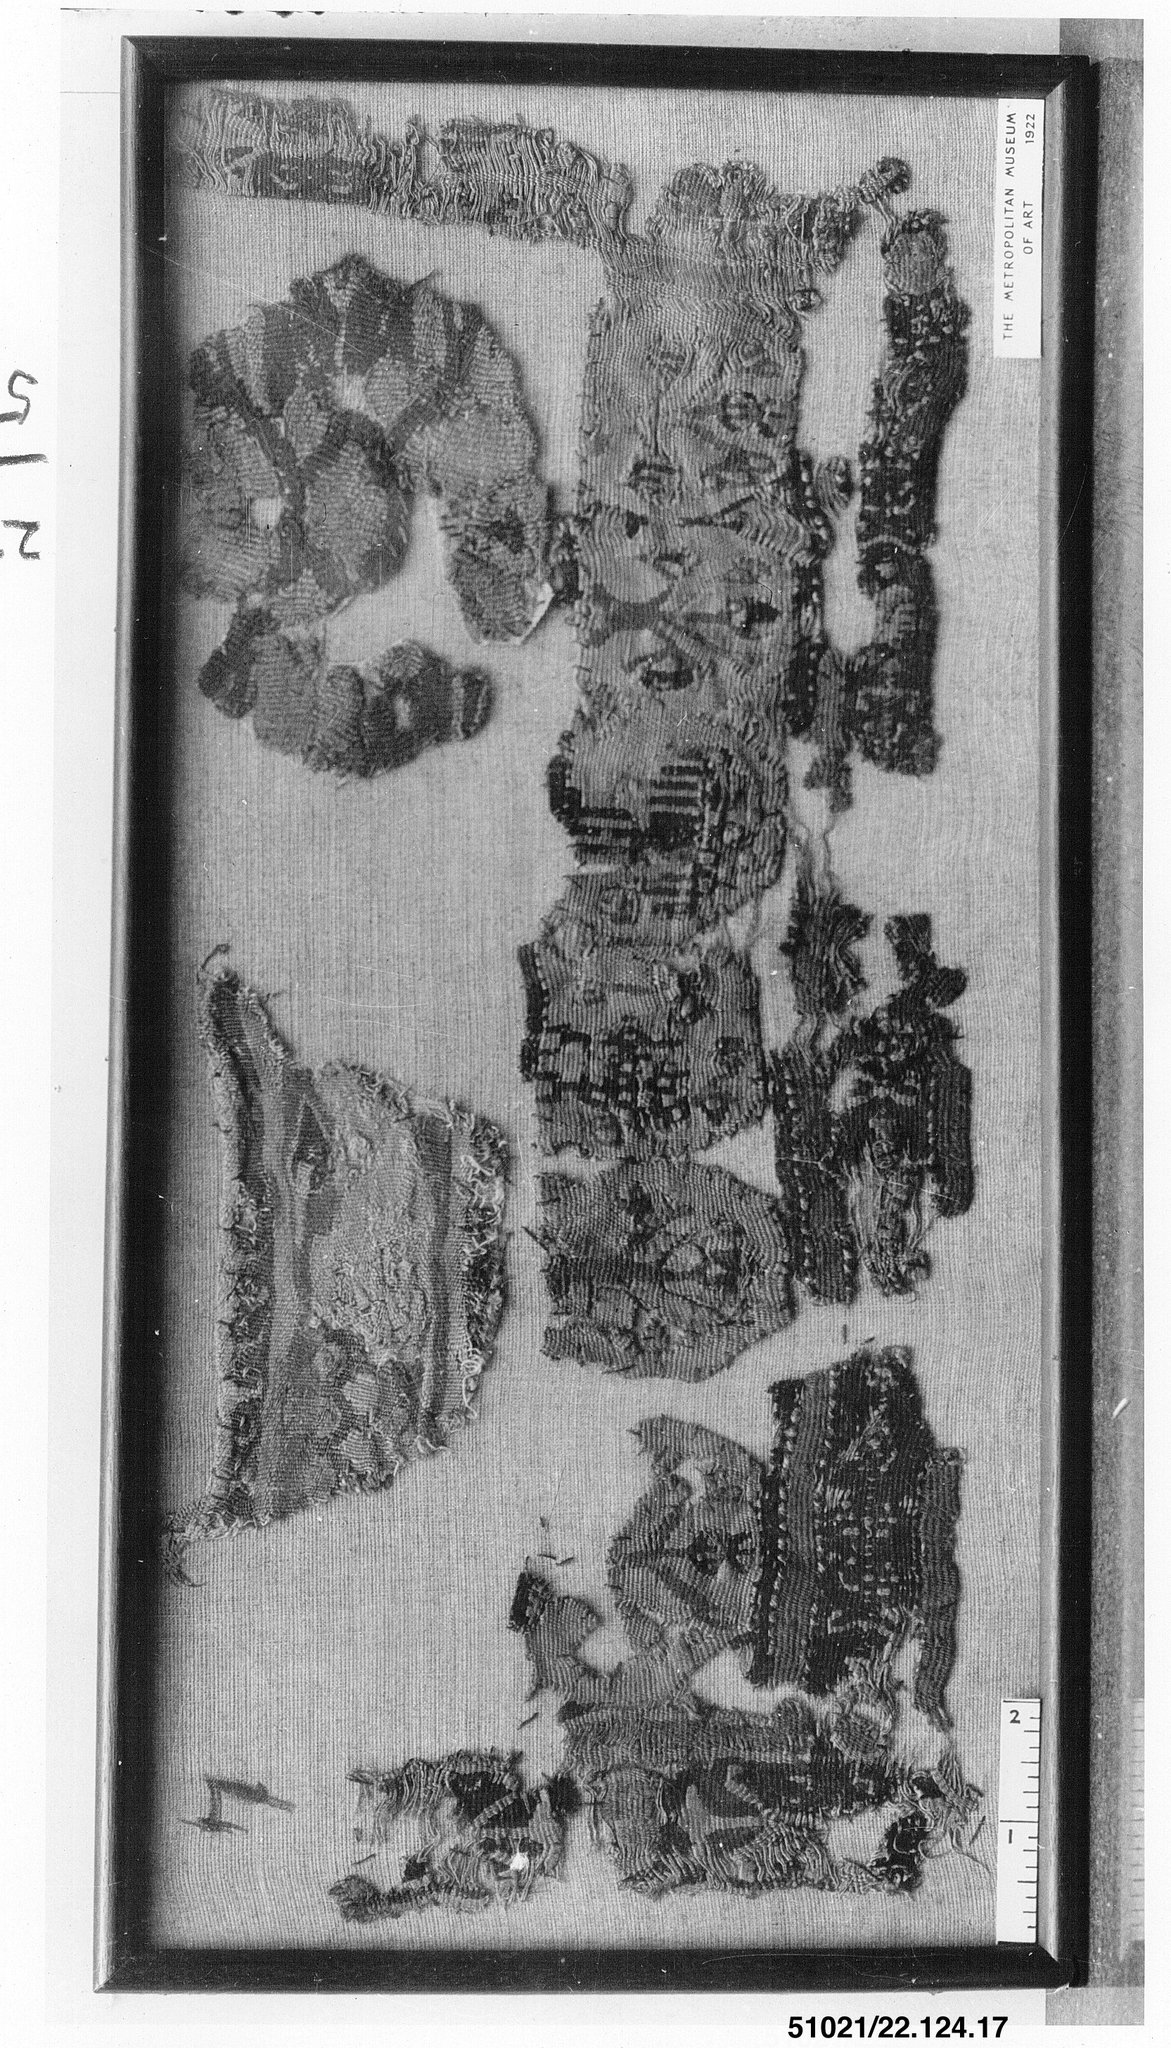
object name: fragment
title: Textile Fragment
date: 301-600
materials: linen, wool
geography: egypt